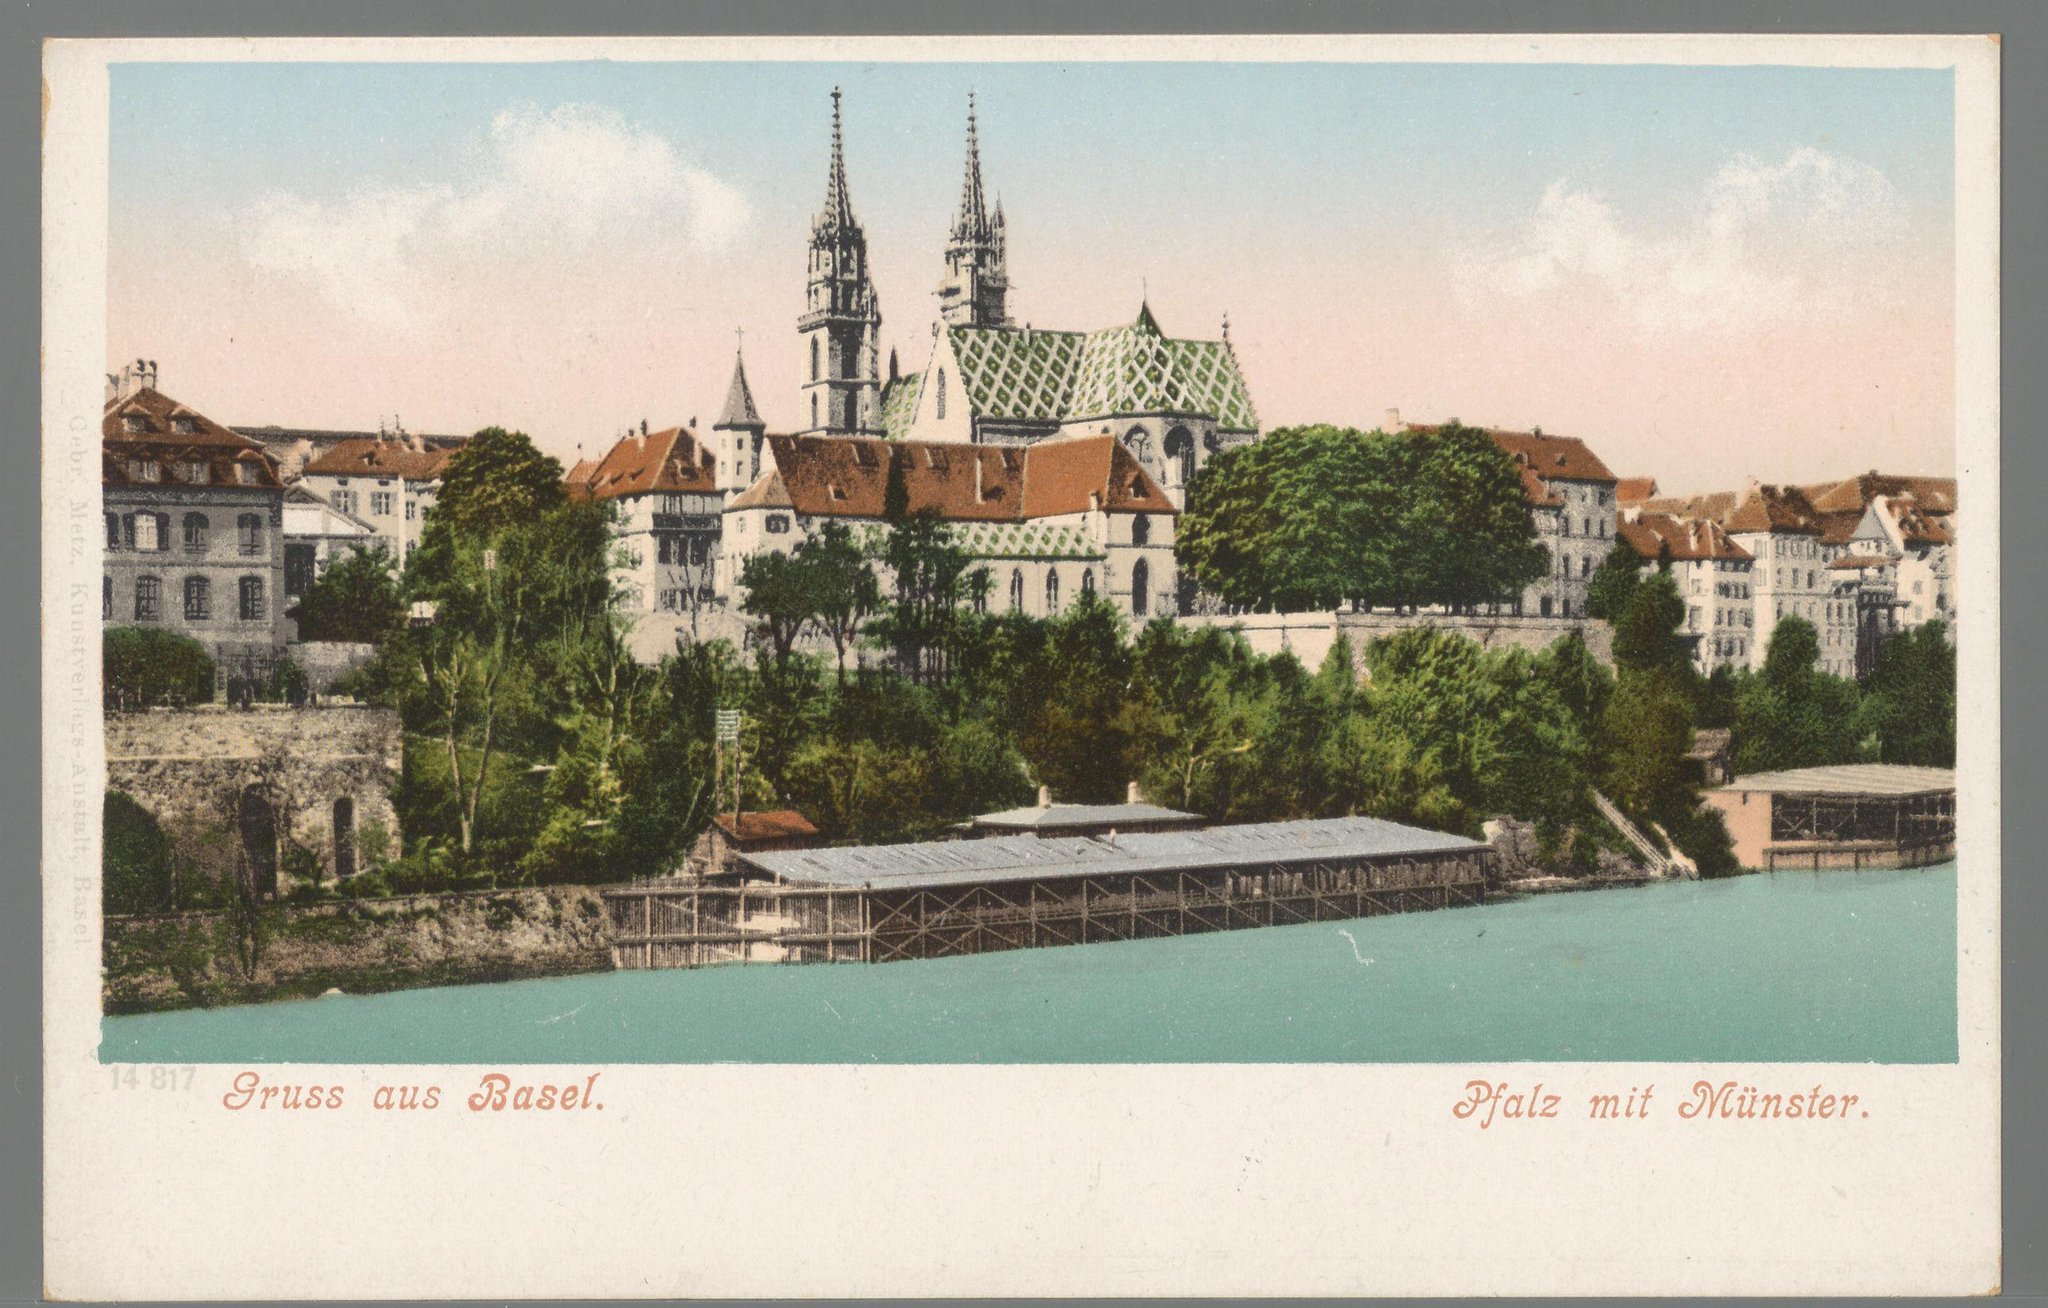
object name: ansichtkaart, prentbriefkaart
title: Pfalz mit Münster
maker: Anonymous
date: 1898-1905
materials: cardboard, photographic process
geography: basel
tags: city-view, and landscape with man-made constructions, church (exterior)